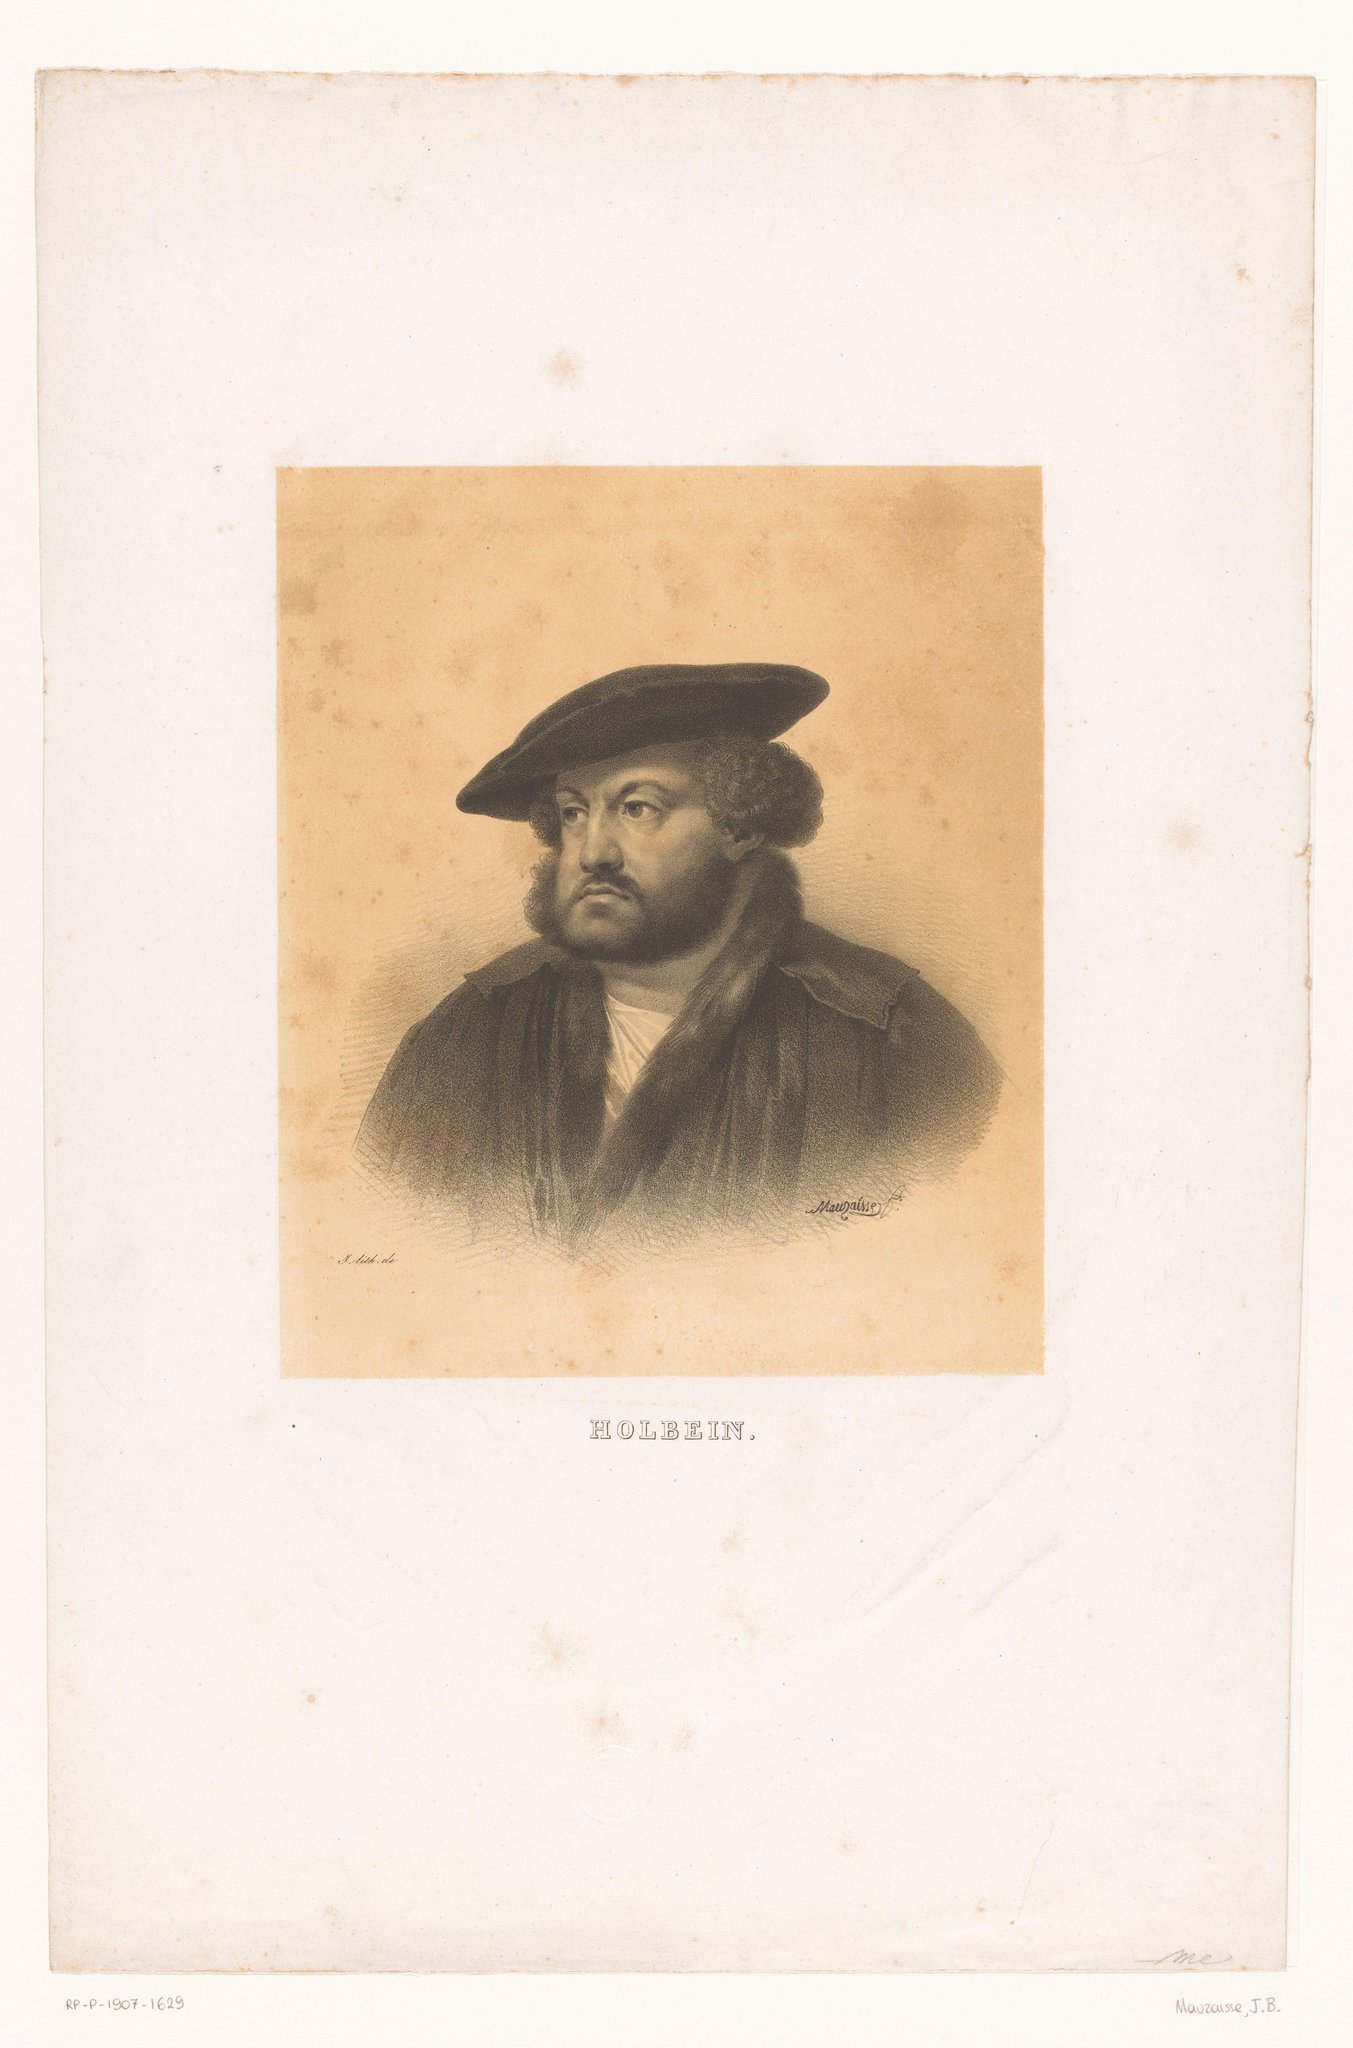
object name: print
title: Holbein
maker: jean baptiste mauzaisse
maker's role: print maker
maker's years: 1784-1844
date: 1820-1830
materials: paper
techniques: tone lithography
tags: augsburg, london, painter, draughtsman, hans holbein (ii), historical persons, portrait, self-portrait of painter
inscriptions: check stamp, collector's mark: Lugt 2228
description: Prent waarschijnlijk ook gebruikt in: Chabert, Jean Claude. Galerie des peintres ou collection de portraits des peintres les plus célèbres de toutes les écoles. Accompagnée d'une notice sur chacun d'eux, et de copies de dessins originaux / Galerie des peintres ou collection de portraits des peintres les plus célèbres de toutes les écoles. Accompagnée de leur notice historique, de leurs dessins et d'un discours sur les arts. Parijs: Jean Claude Chabert, s.a. [1822-1834]. De samenstelling van tegenwoordig bekende en al dan niet gebonden exemplaren van deze uitgave verschillen. Dit omdat de prenten en bijhorende stukken tekst op inschrijving en waarschijnlijk ook los verkrijgbaar waren.